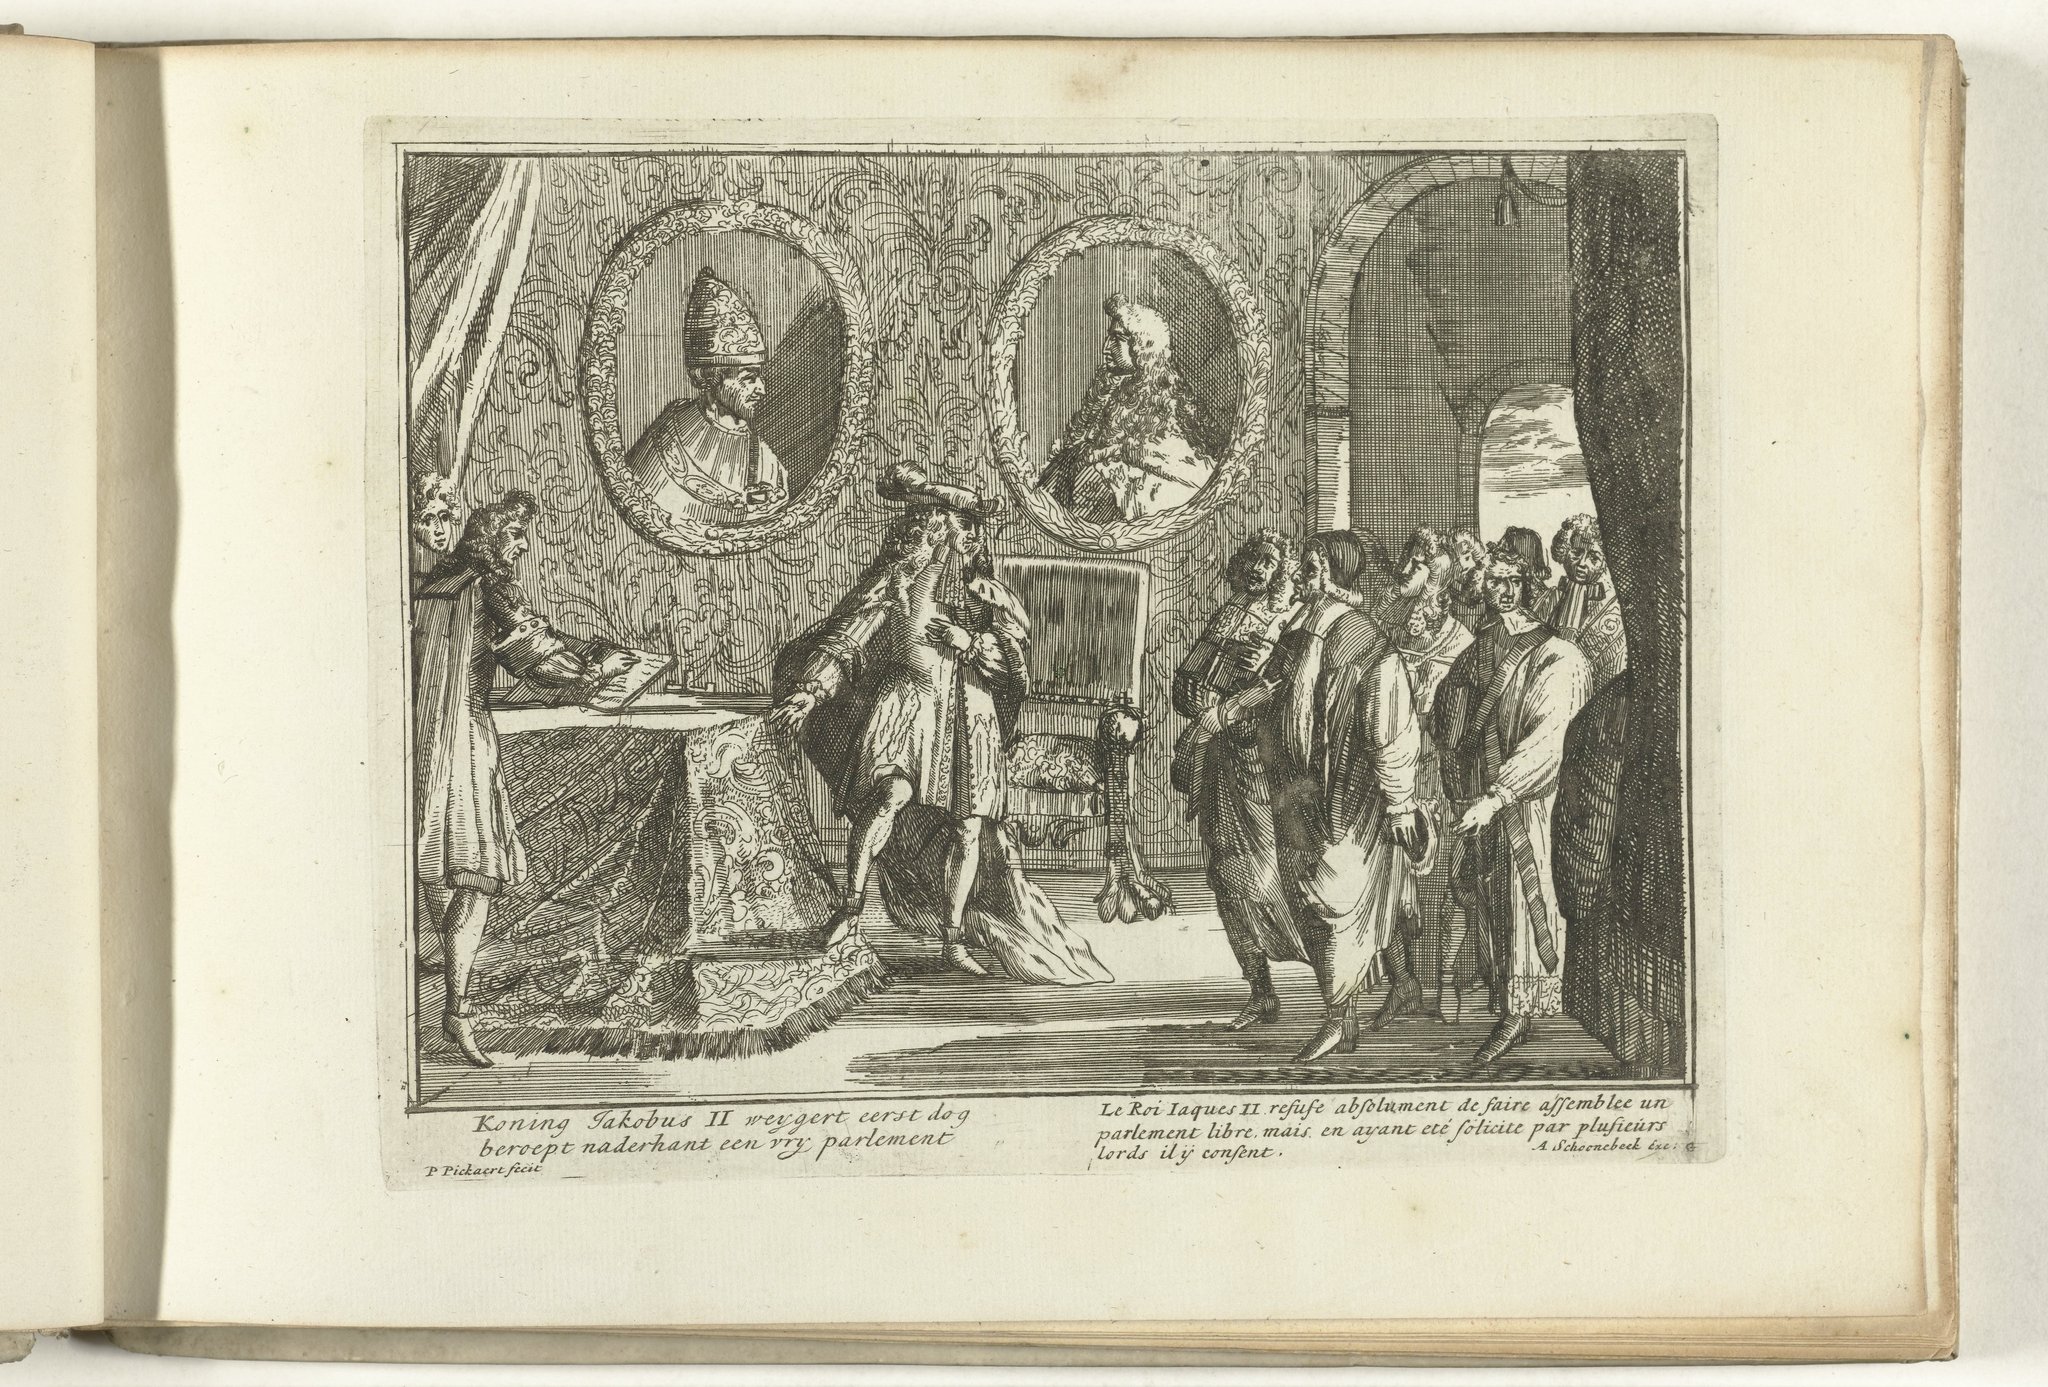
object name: print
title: Jacobus II beroept een vrij parlement, 1688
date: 1689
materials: paper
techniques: etching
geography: amsterdam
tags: jacobus ii (koning van engeland en schotland), rome, clergyman, innocentius xi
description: Koning Jacobus II wordt door leden van het parlement na een aanvankelijke weigering overgehaald om een vrij parlement bijeen te roepen. Links de koning staande bij een tafel, aan de wand grote portretten van de paus en Lodewijk XIV (?). Plaat G in de serie 'Engelants schouwtoneel' over de Glorious Revolution en gebeurtenissen uit de voorafgaande jaren 1685-1689 (eerste deel). Met onderschriften in het Nederlands en Frans.